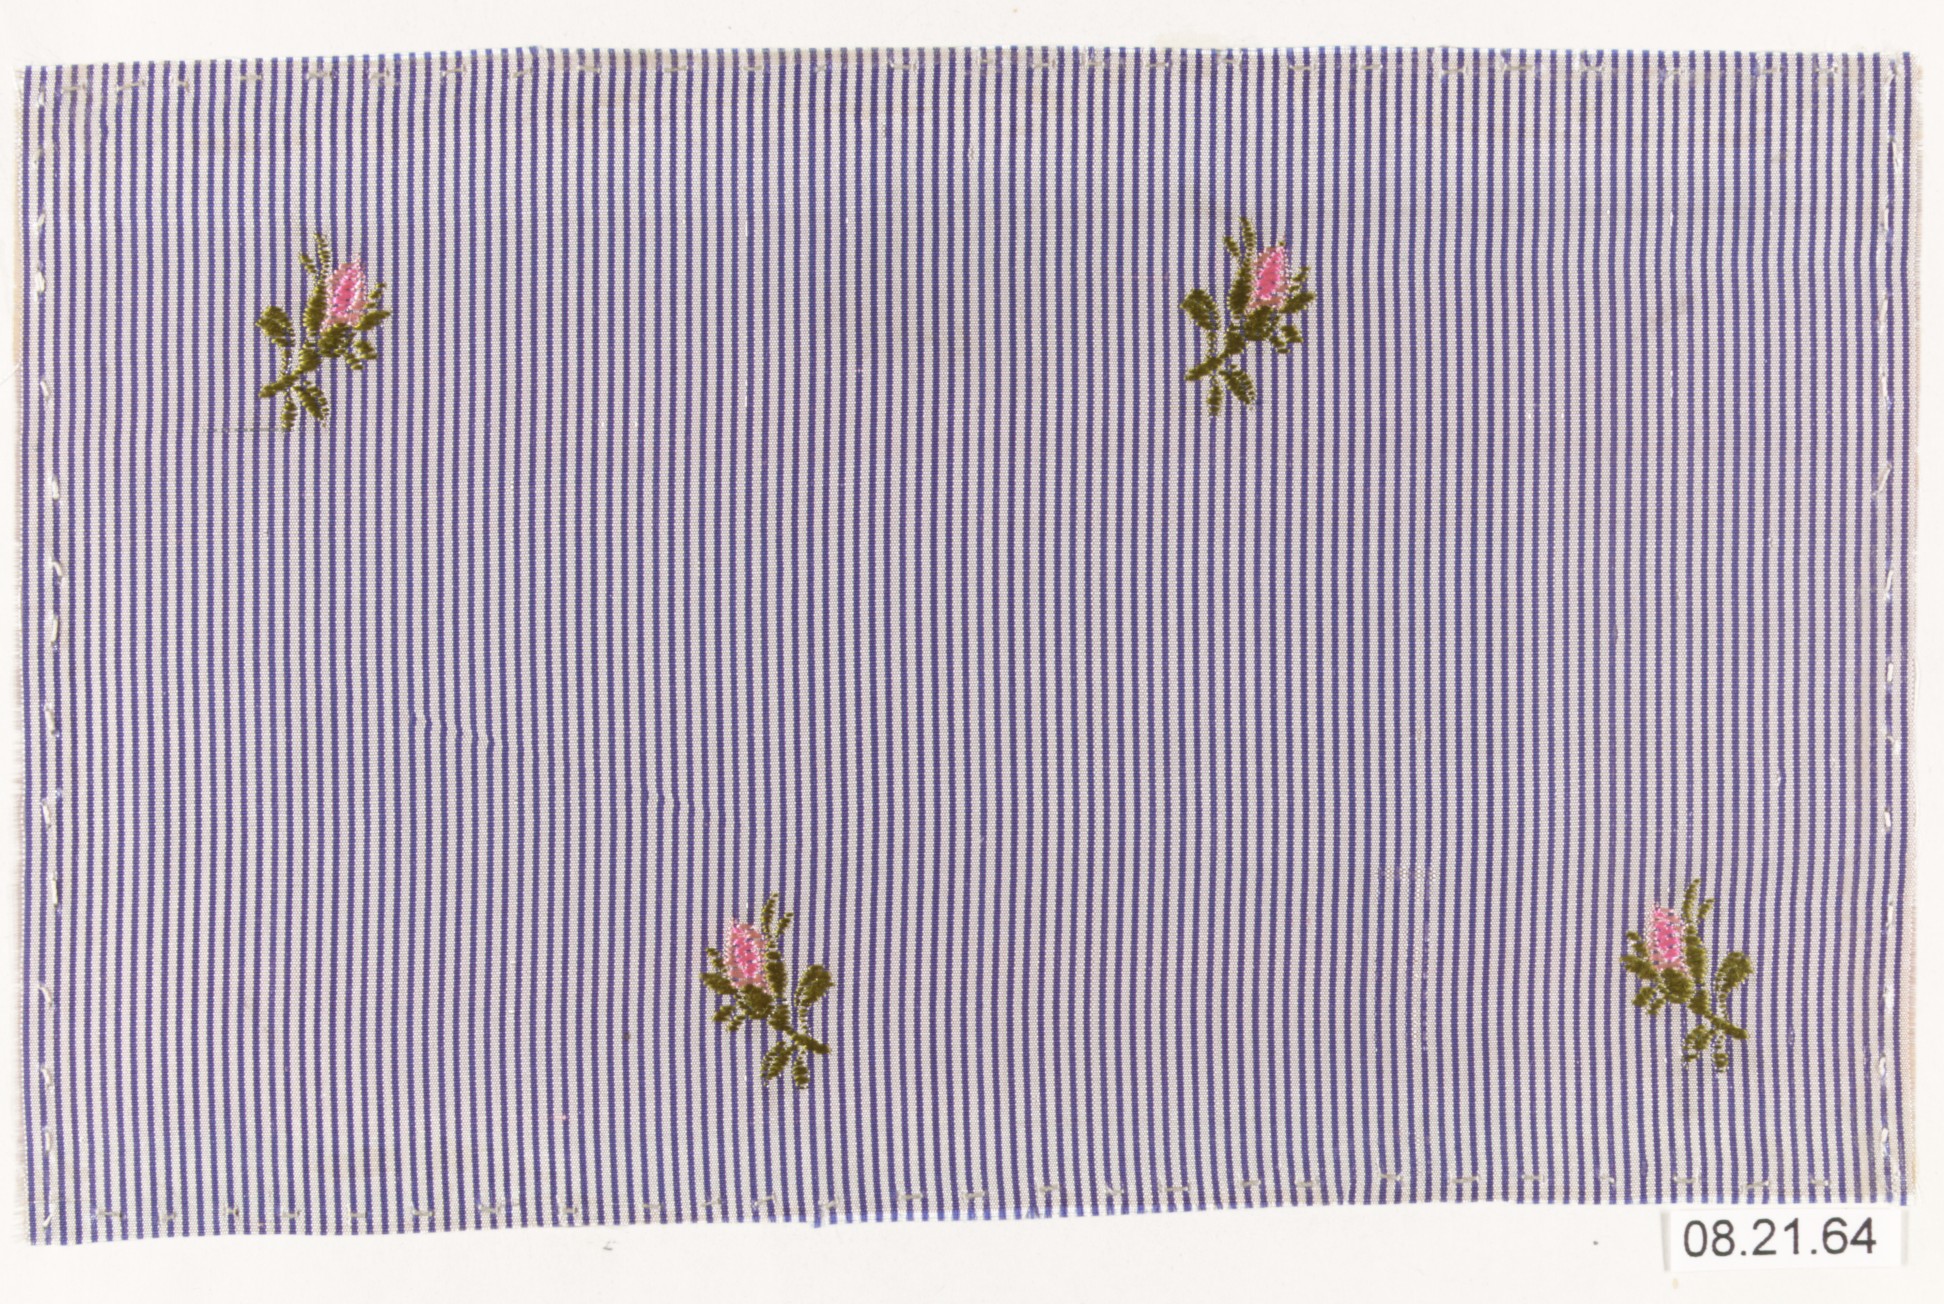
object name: textile sample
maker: Anonymous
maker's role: designer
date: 1900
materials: silk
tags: flowers